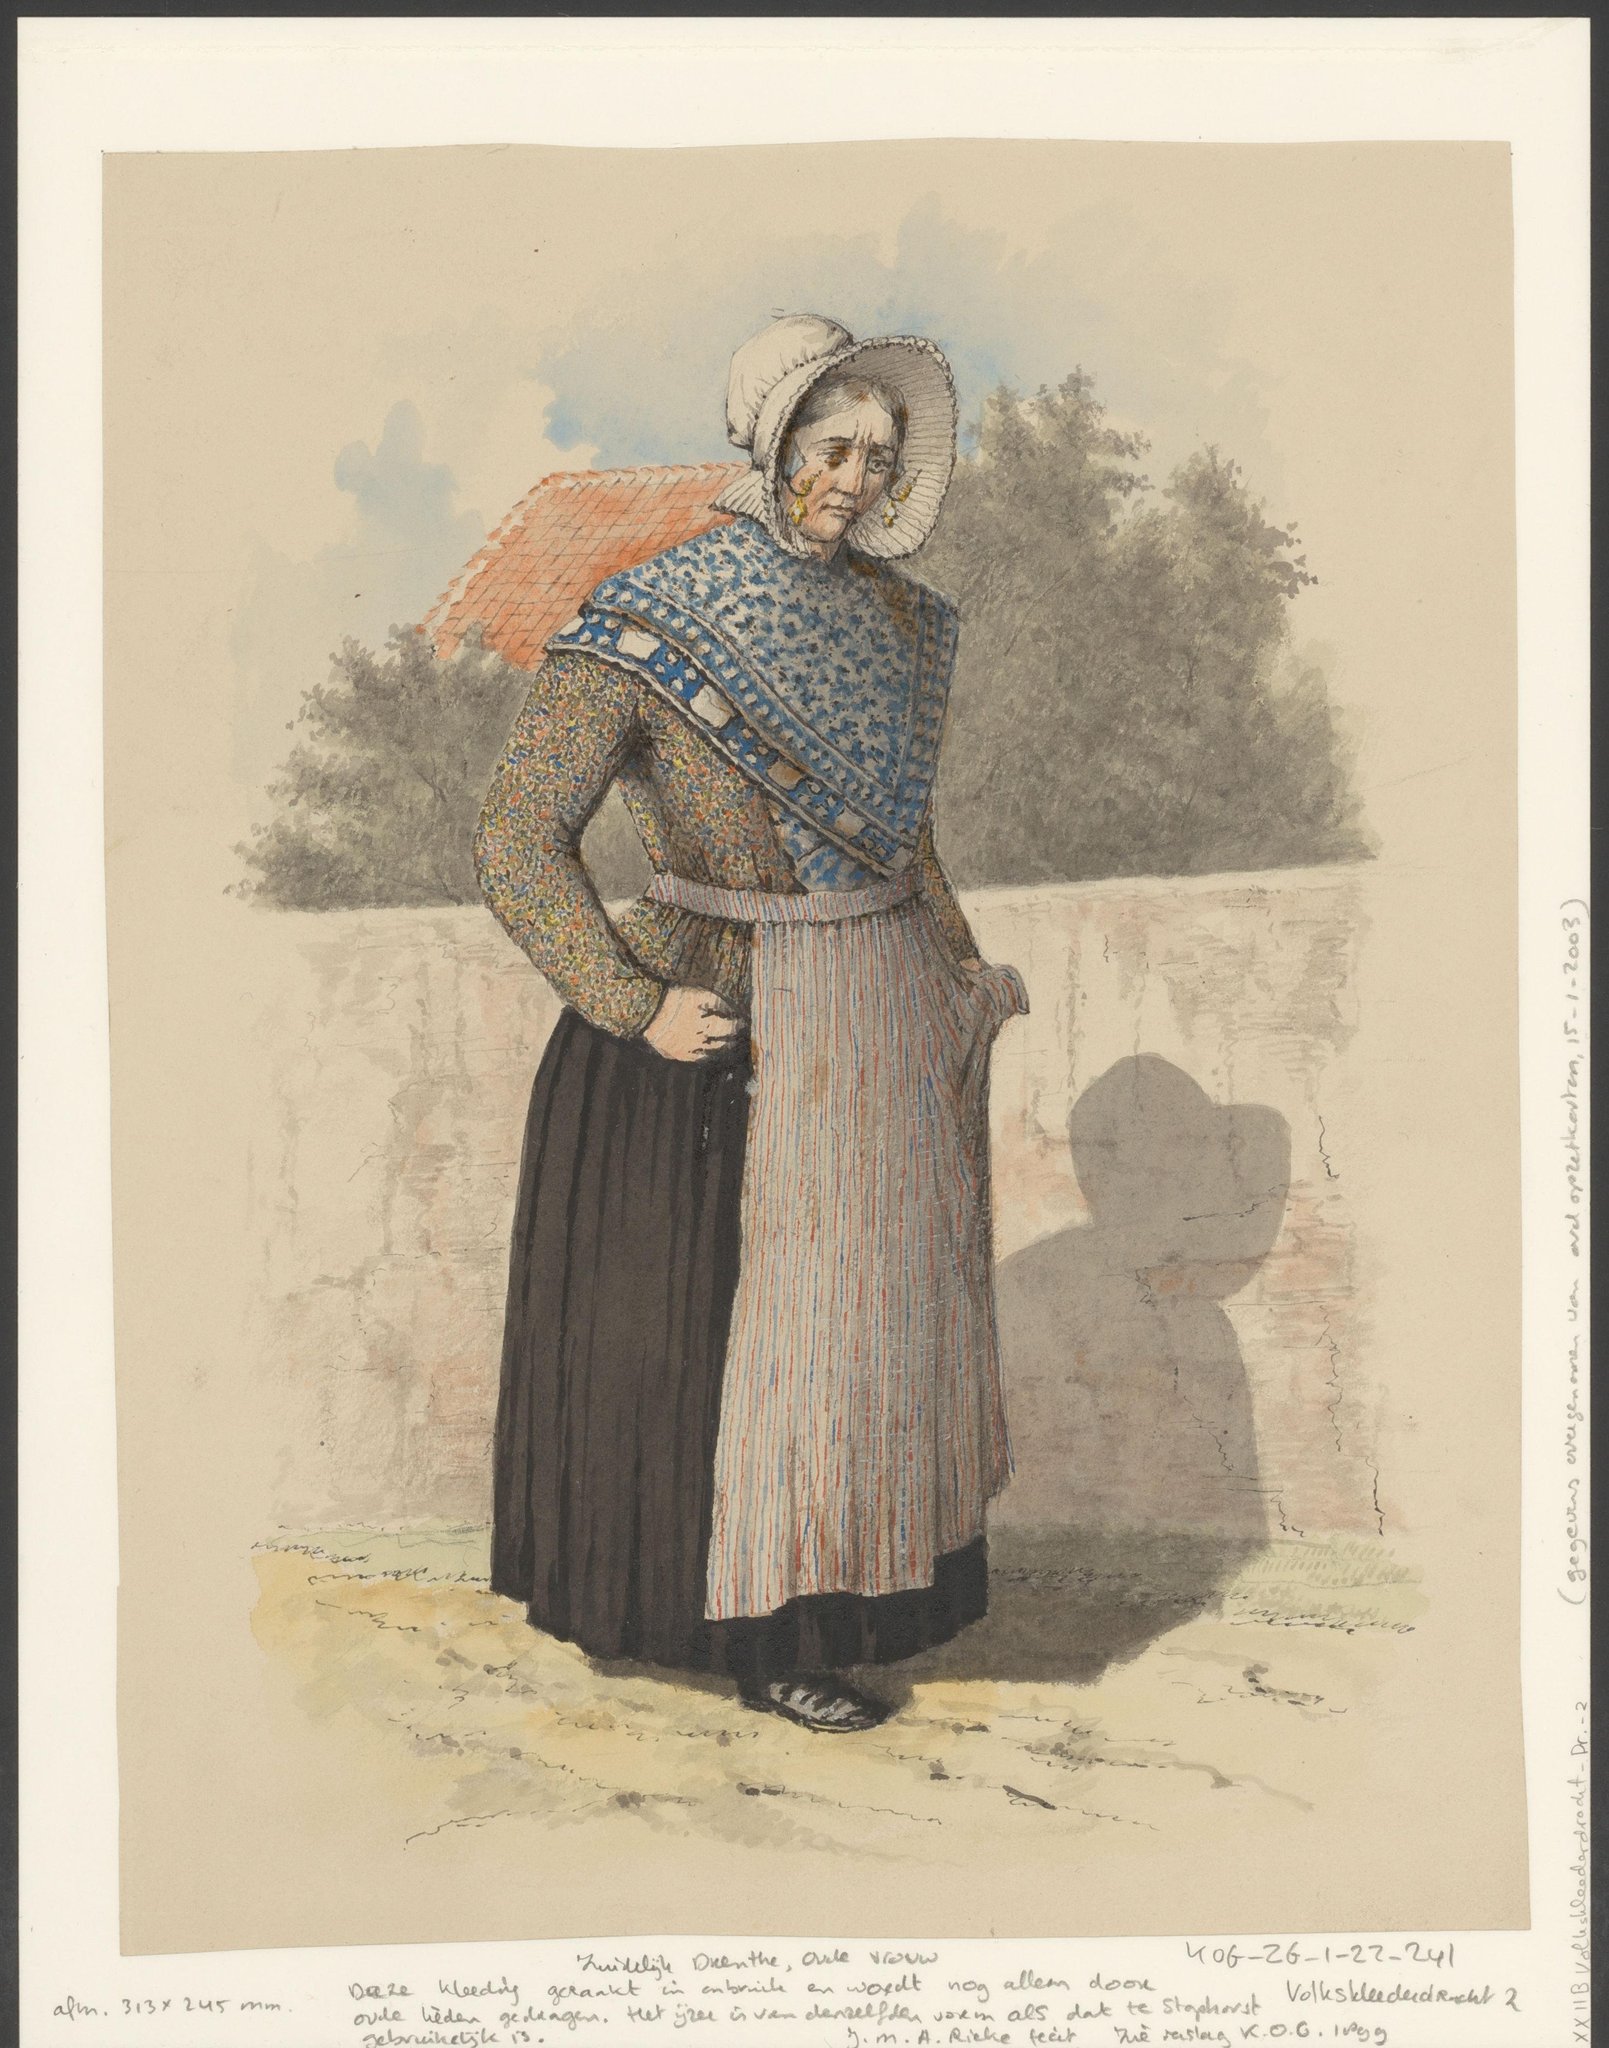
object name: drawing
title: Oude vrouw uit het zuiden van Drenthe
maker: johan martinus anthon rieke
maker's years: 1851-1899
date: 1896-1898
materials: paper, watercolor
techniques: brush, hand coloring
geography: netherlands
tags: clothes, costume (+ women's clothes), old woman, folk costume, regional costume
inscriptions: collector's mark, collector's mark: Lugt 1641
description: Oude vrouw uit het zuiden van Drenthe. Tekening vervaardigd voor de tentoonstelling over Nederlandse klederdrachten gehouden in het Stedelijk Museum te Amsterdam in september 1898. Onderwerpsrubrieken binnen de Atlas Zeden en Gewoonten: De Kleeding, Volkskleederdracht, Drenthe.